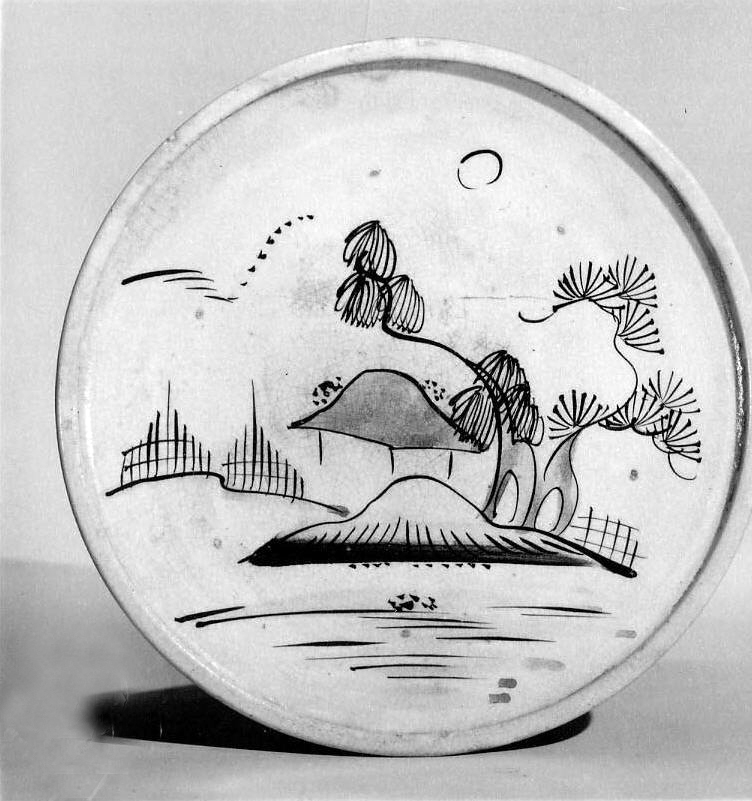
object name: plate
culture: japanese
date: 1801-1900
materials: pottery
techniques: painting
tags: houses,trees